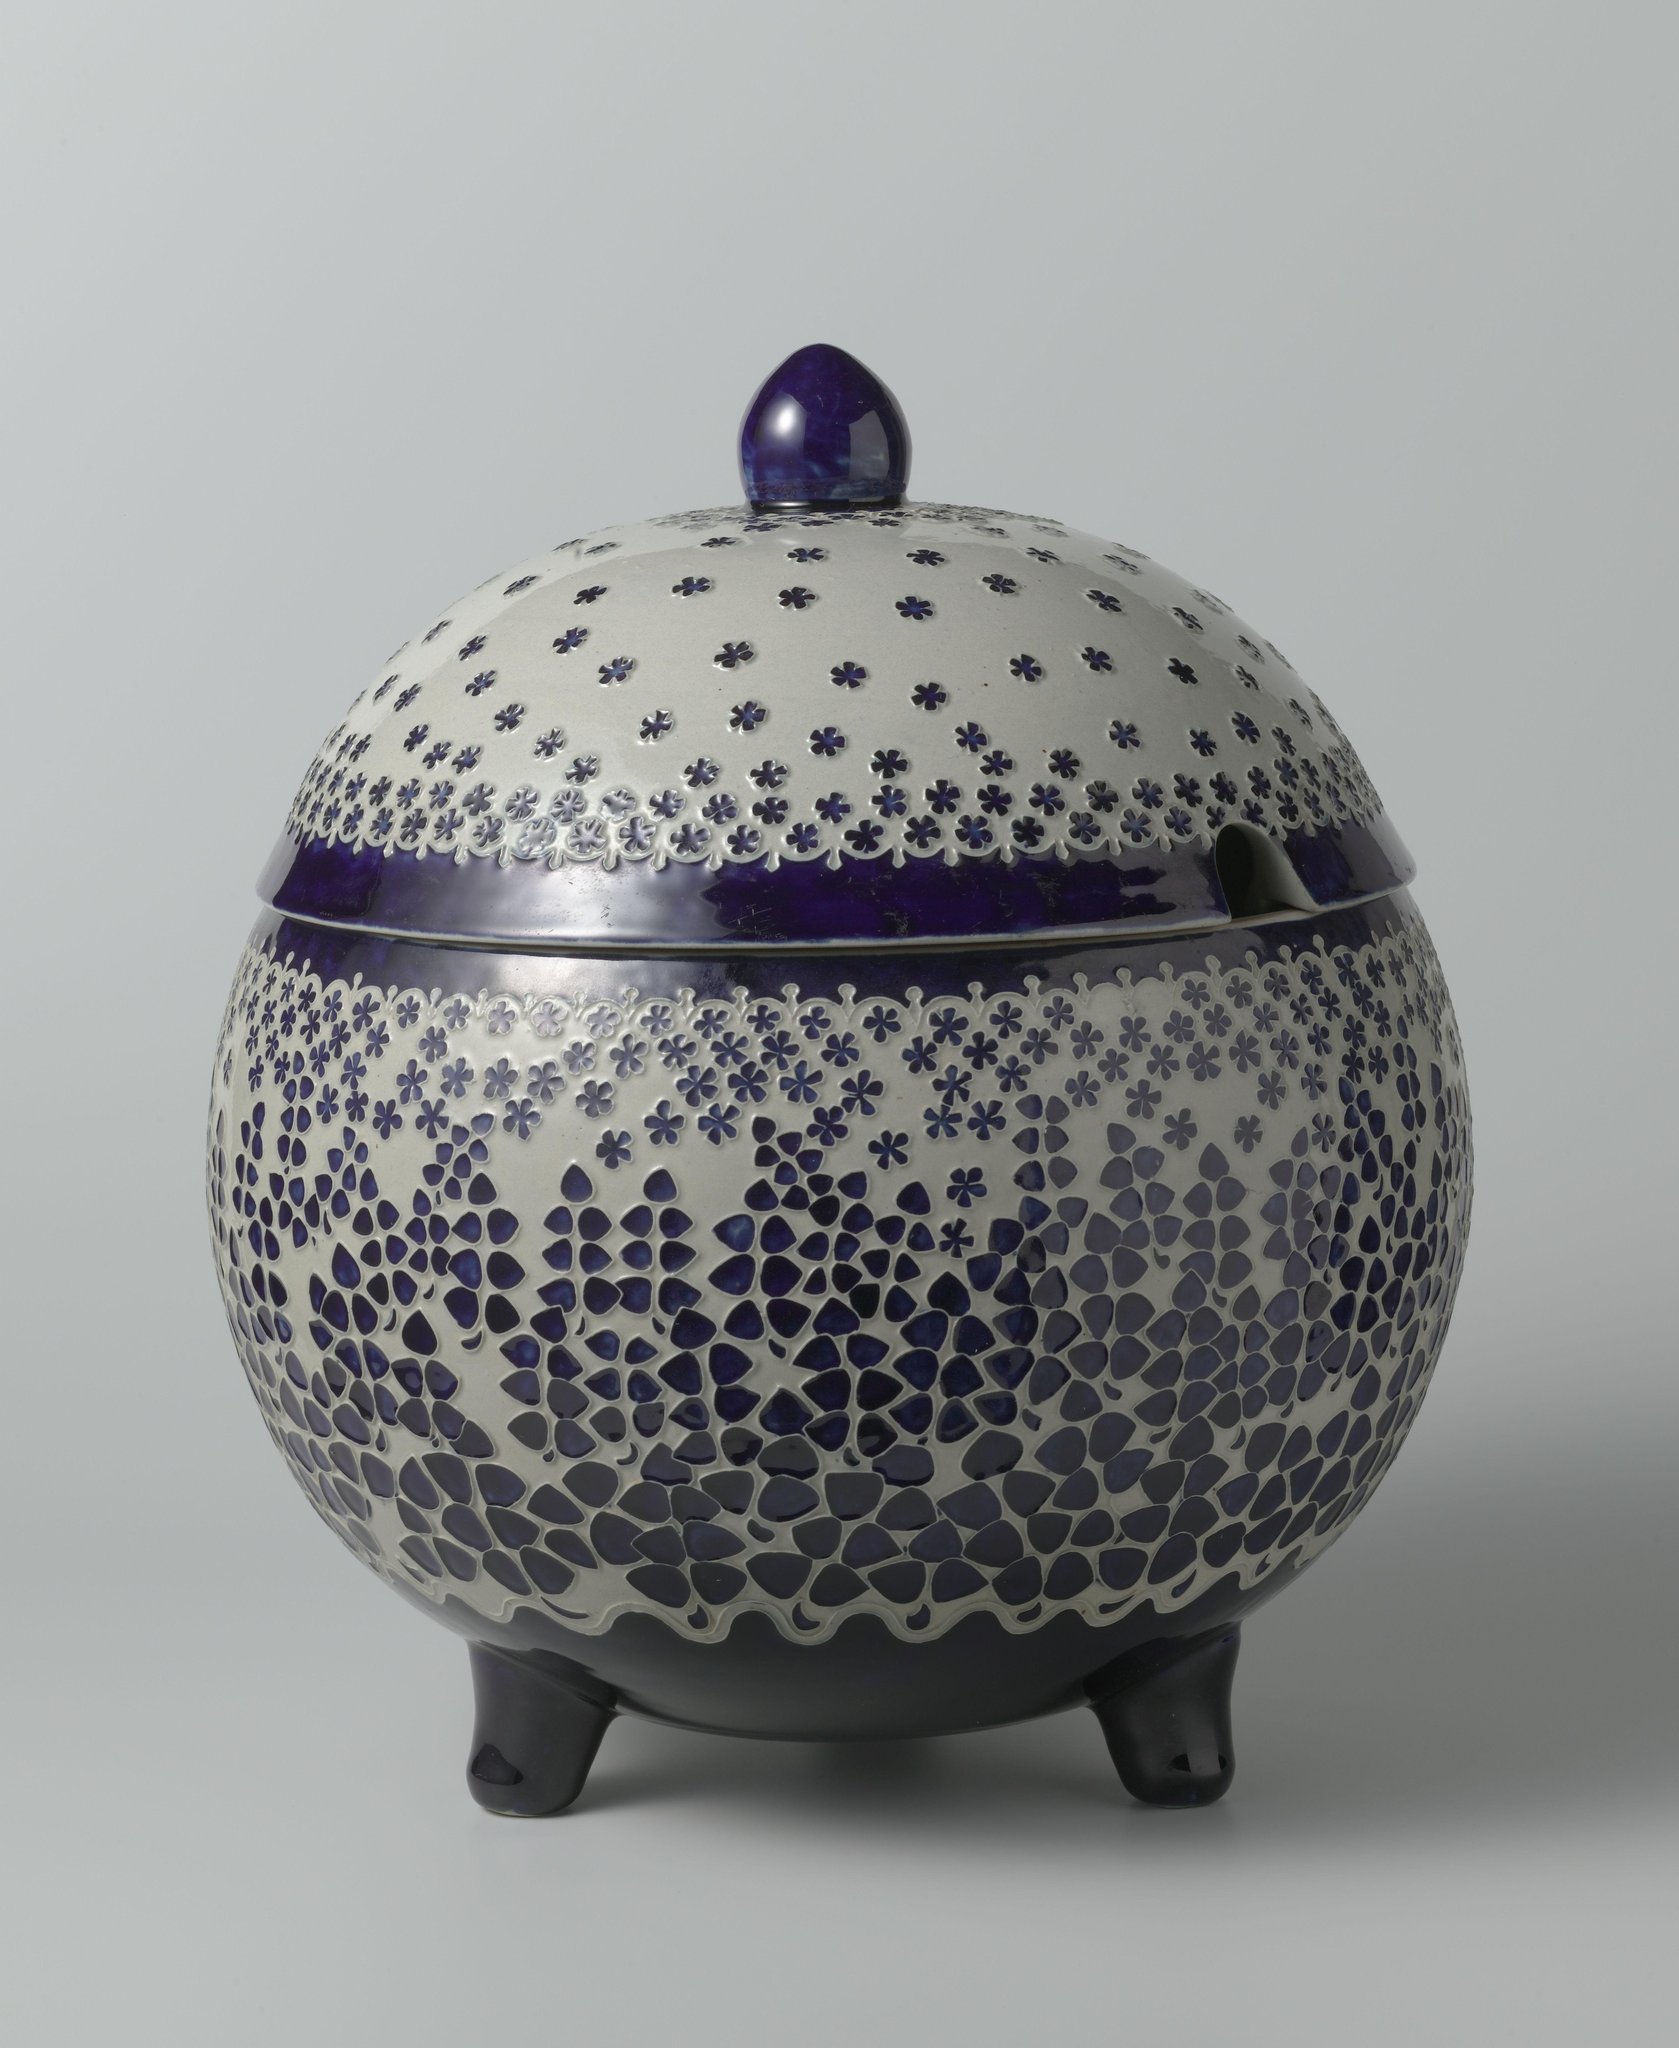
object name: lid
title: Deksel van punchkom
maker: richard riemerschmid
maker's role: designer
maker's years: 1868-1957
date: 1902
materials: stoneware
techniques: vitrification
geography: munich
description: Deksel van bolvormige punchkom op drie pootjes.